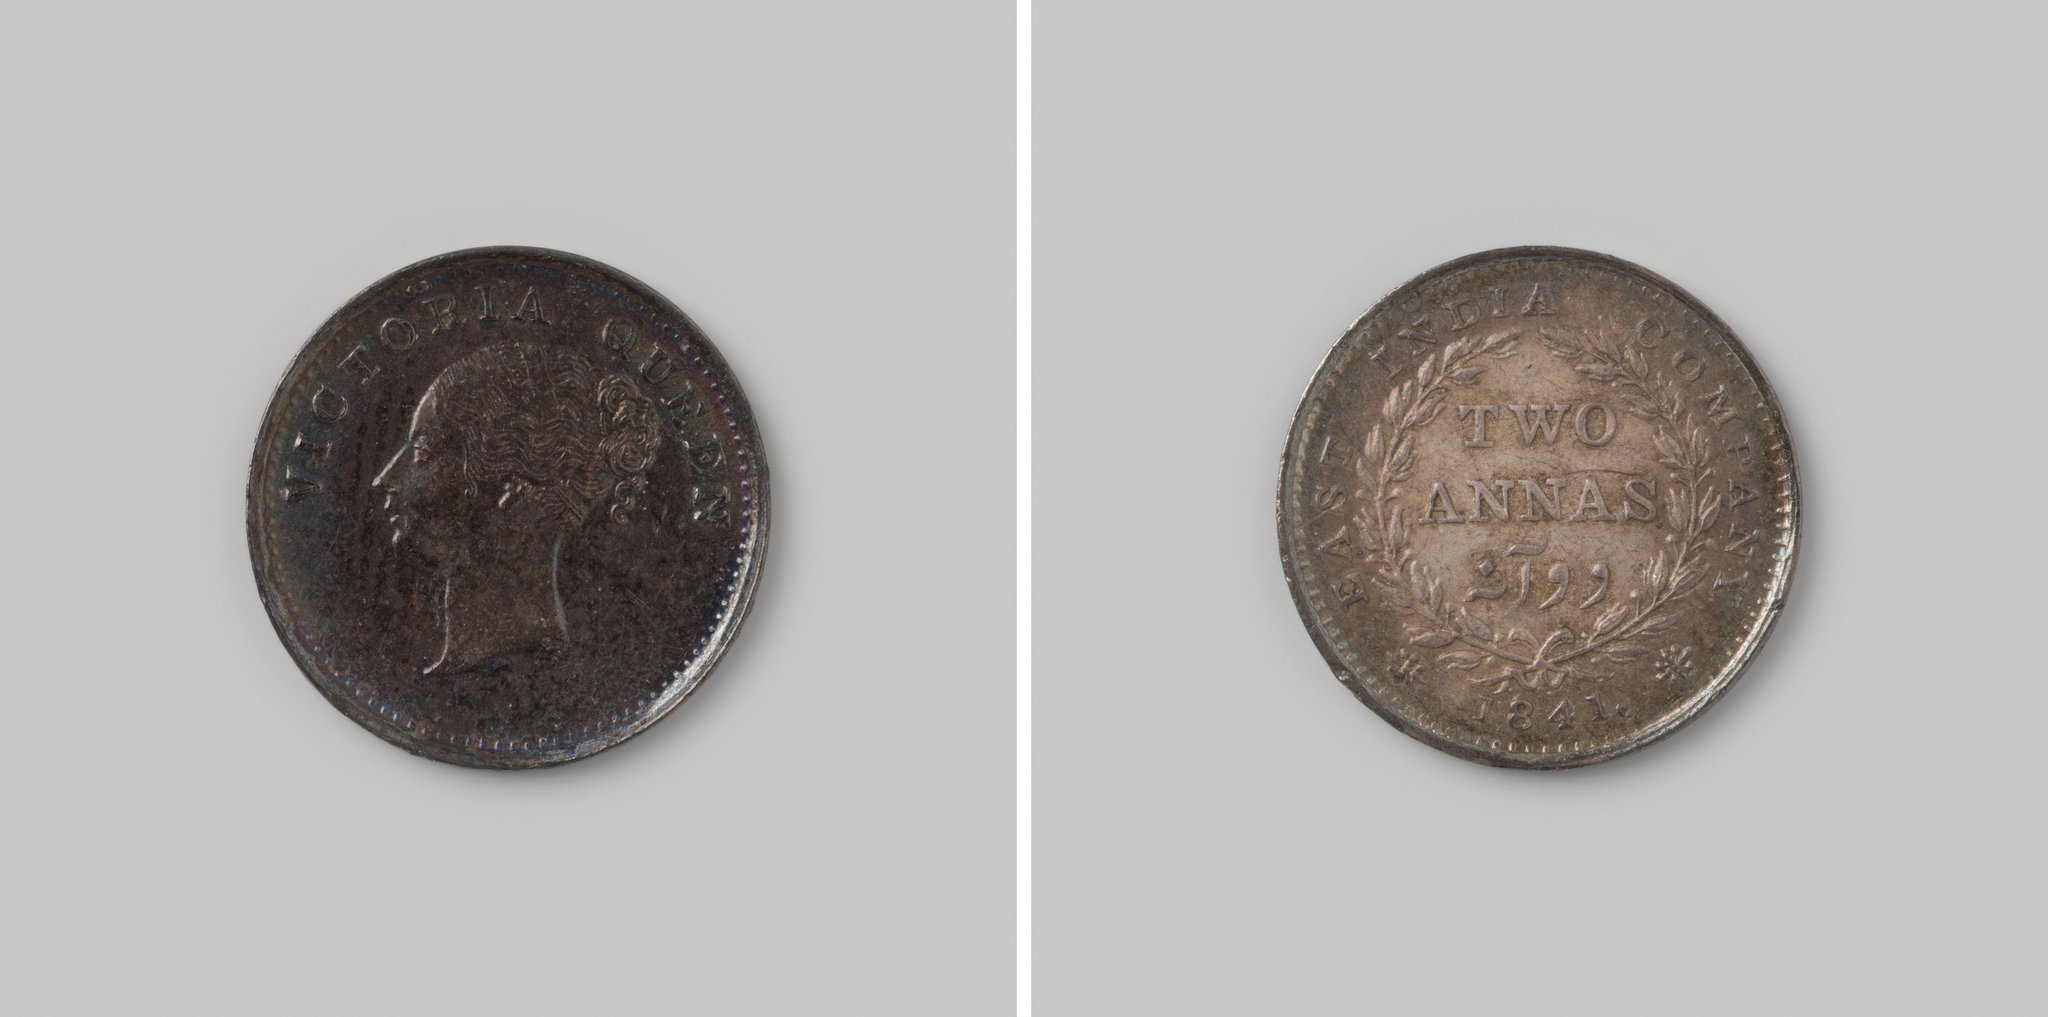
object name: coin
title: 2 annas uit India van de Engelse Oostindische Compagnie (EIC) op naam van koningin Victoria, 1841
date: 1841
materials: silver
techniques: striking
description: Zilveren munt. Voorzijde: hoofd van koningin Victoria naar links. Omschrift doorlopend. Keerzijde: tussen twee samengebonden takken in twee regels waarde-aanduiding: two annas, waaronder in Arabische lettertekens in een regel waarde-aanduiding. Onderaan jaartal. Gladde rand.